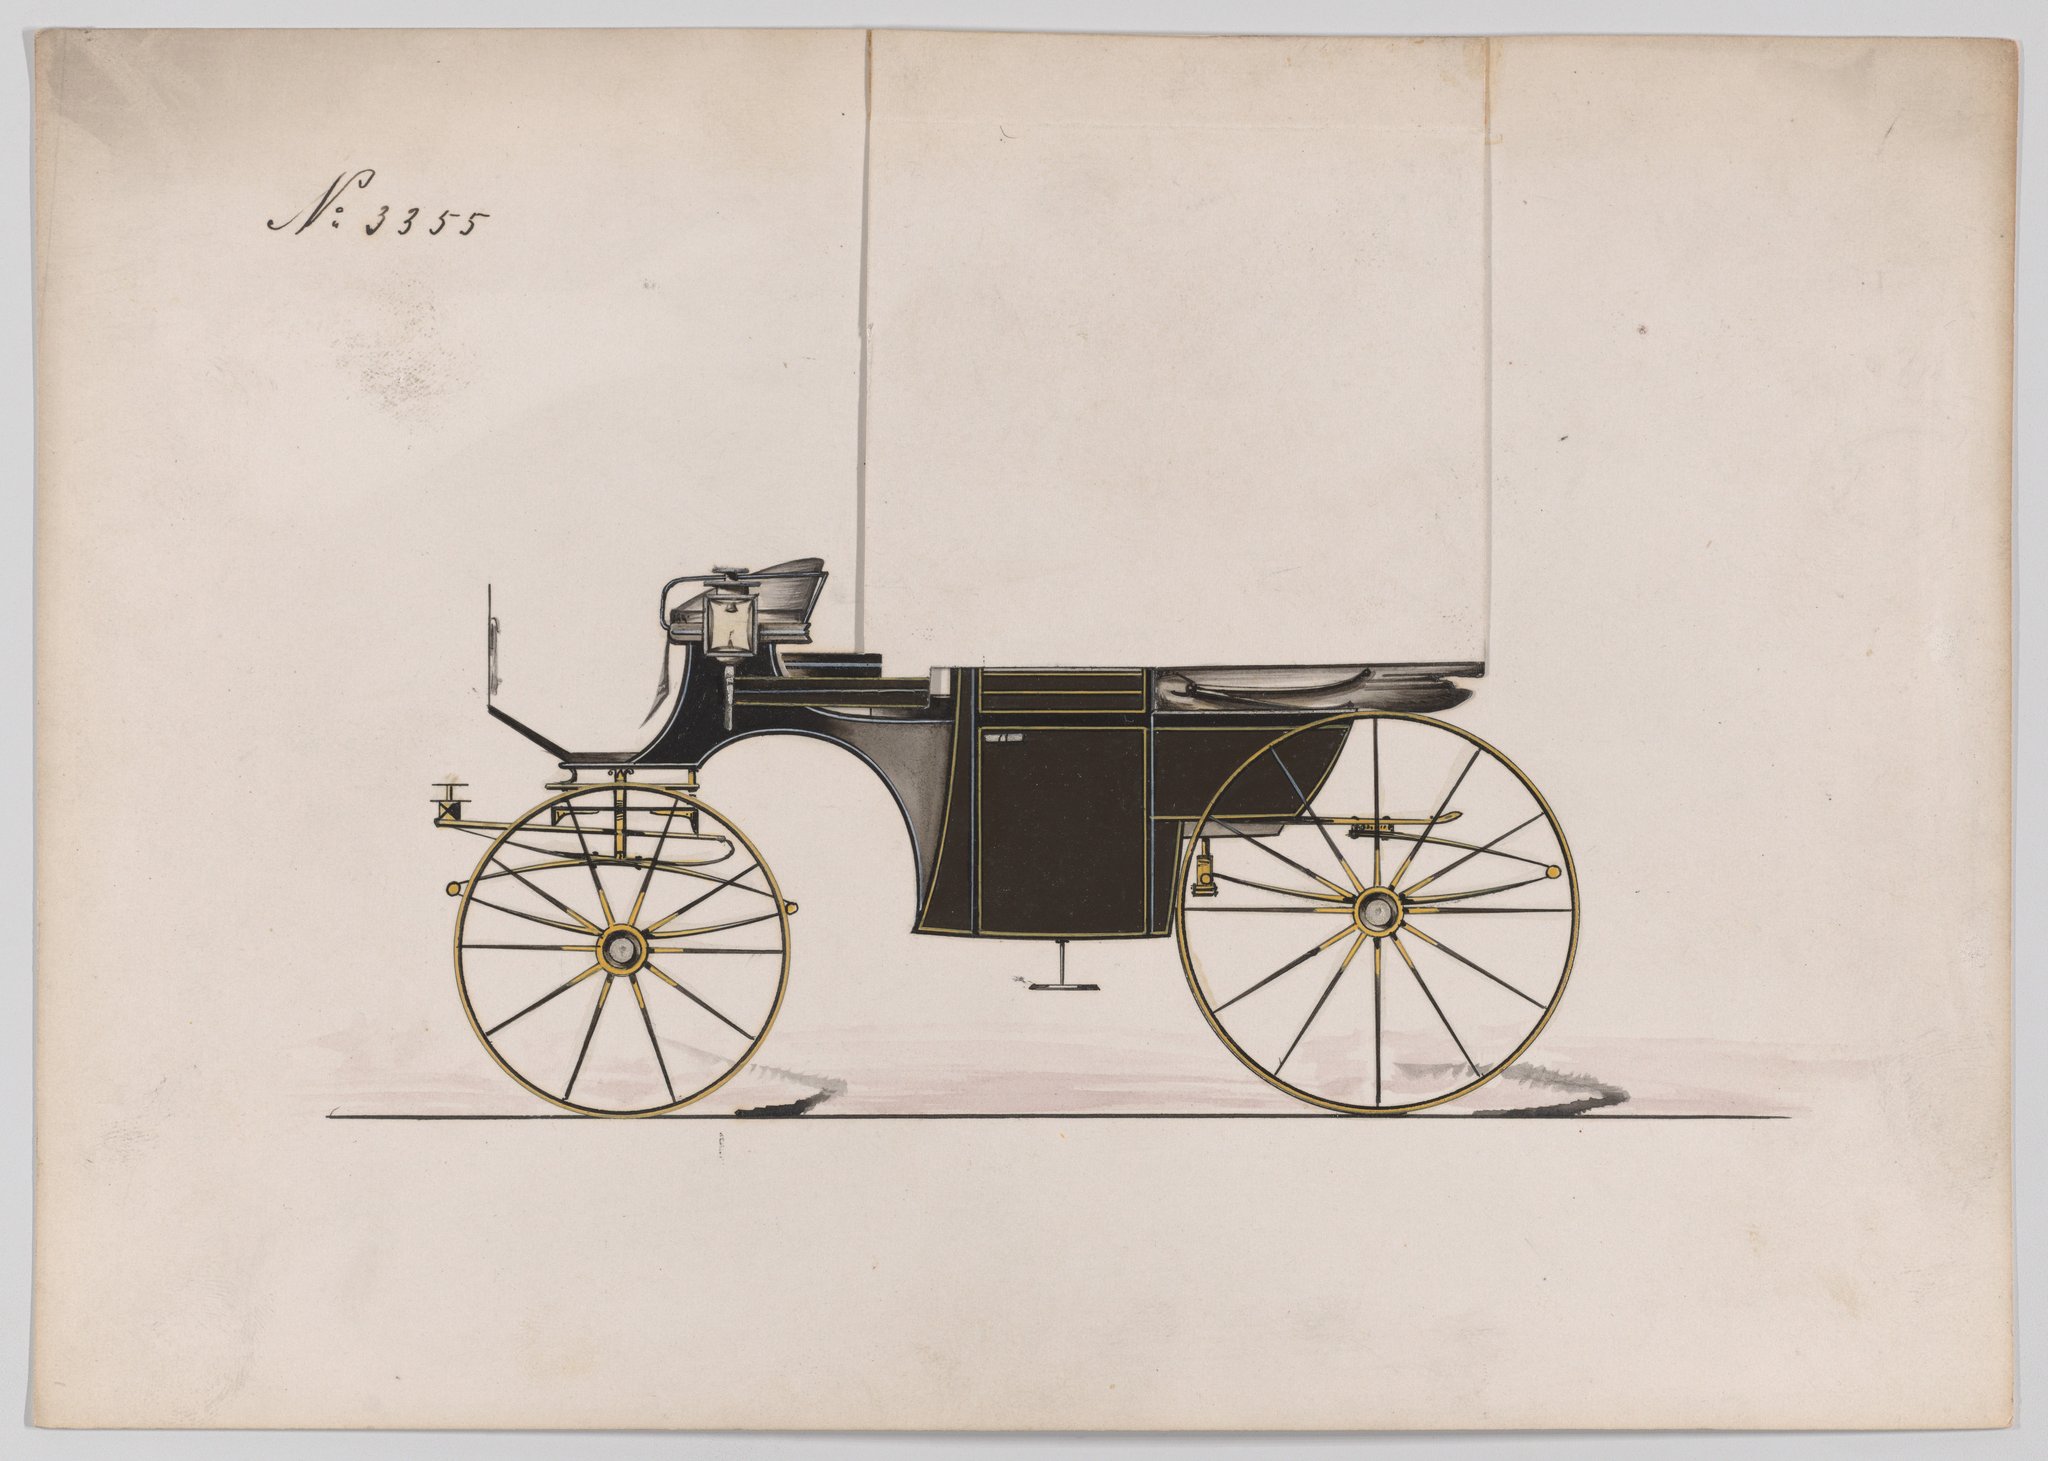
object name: drawing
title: Design for Landaulet, no. 3355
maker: brewster & co.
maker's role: manufacturer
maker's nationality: american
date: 1877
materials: gouache, gum arabic, ink, watercolor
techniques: pen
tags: carriages